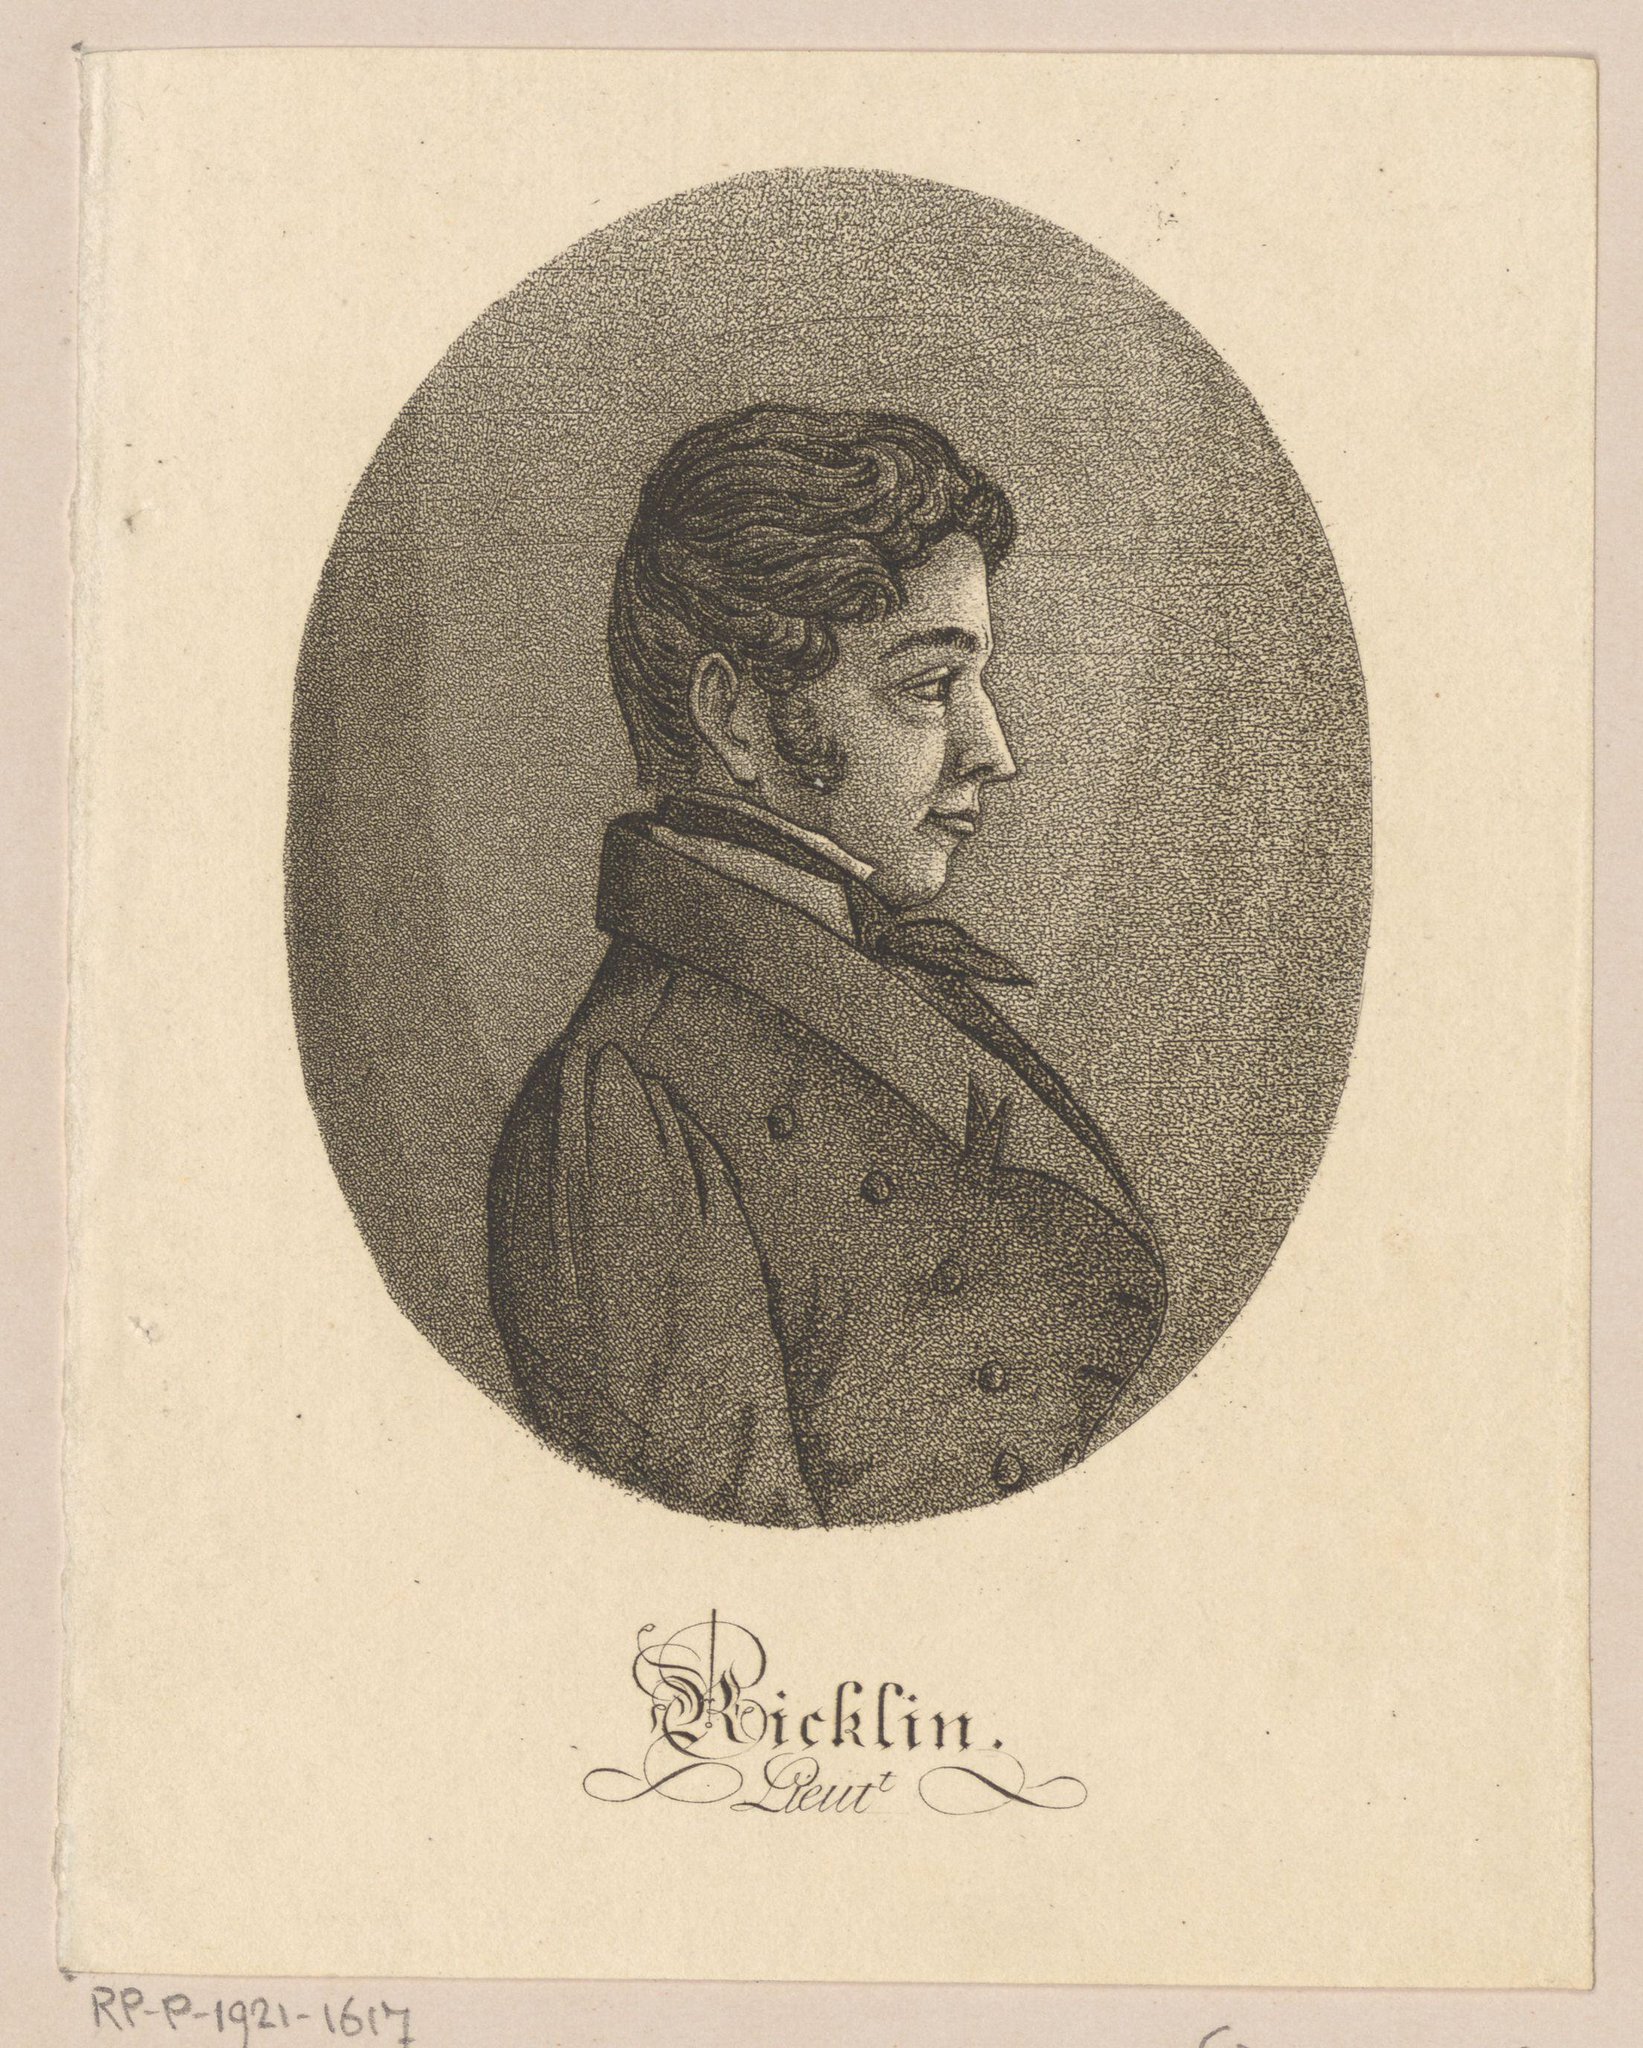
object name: print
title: Portret van Ricklin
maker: Anonymous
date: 1800-1899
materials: paper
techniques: aquatint, engraving, etching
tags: historical persons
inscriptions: collector's mark: Lugt 2233